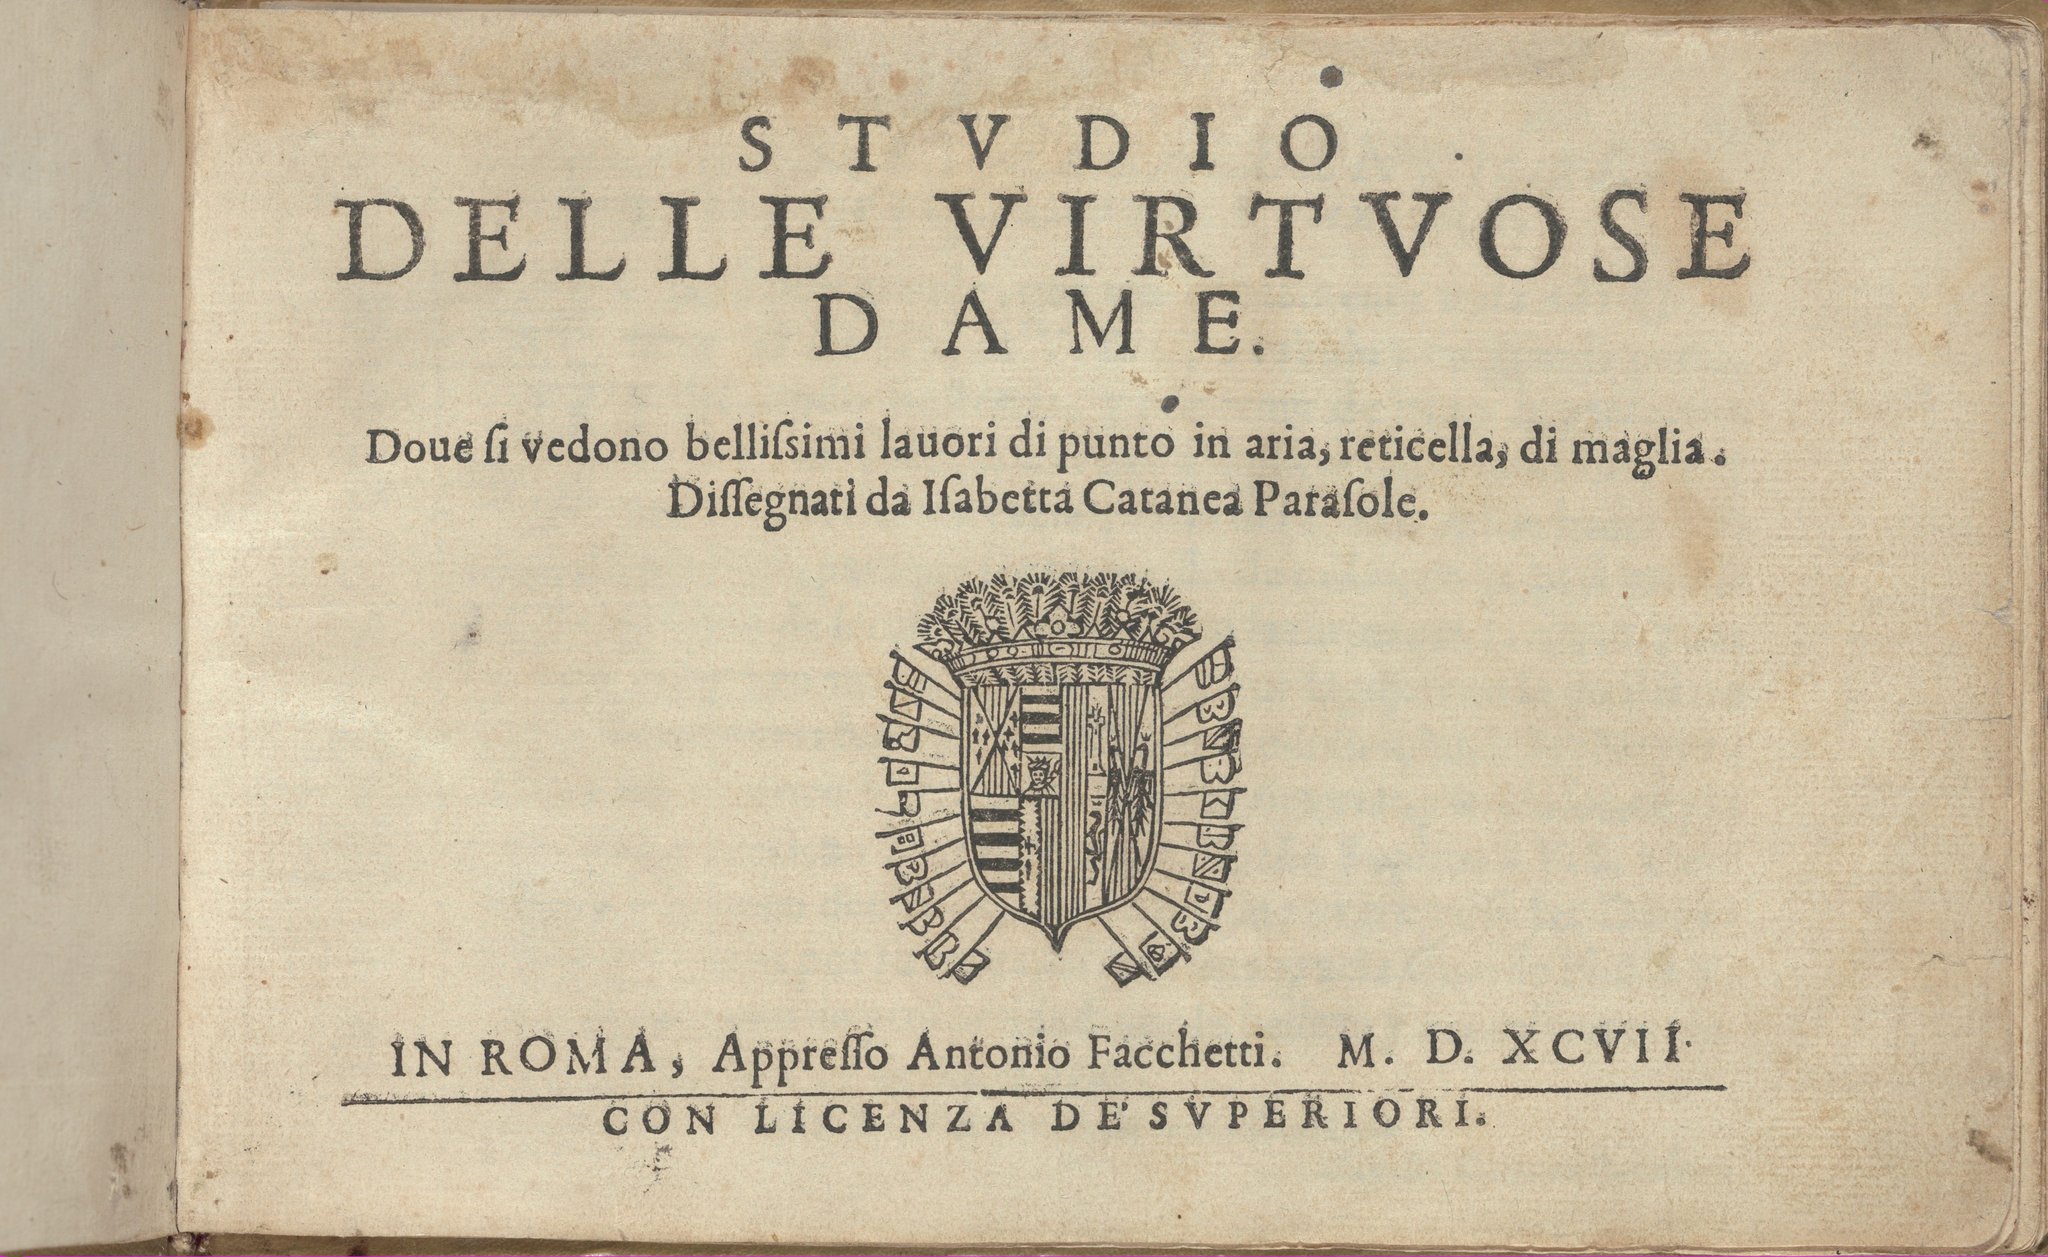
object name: book print ornament architecture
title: Studio delle virtuose Dame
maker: isabella catanea parasole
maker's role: designer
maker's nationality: italian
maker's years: 1565-1625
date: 1597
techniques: woodcut